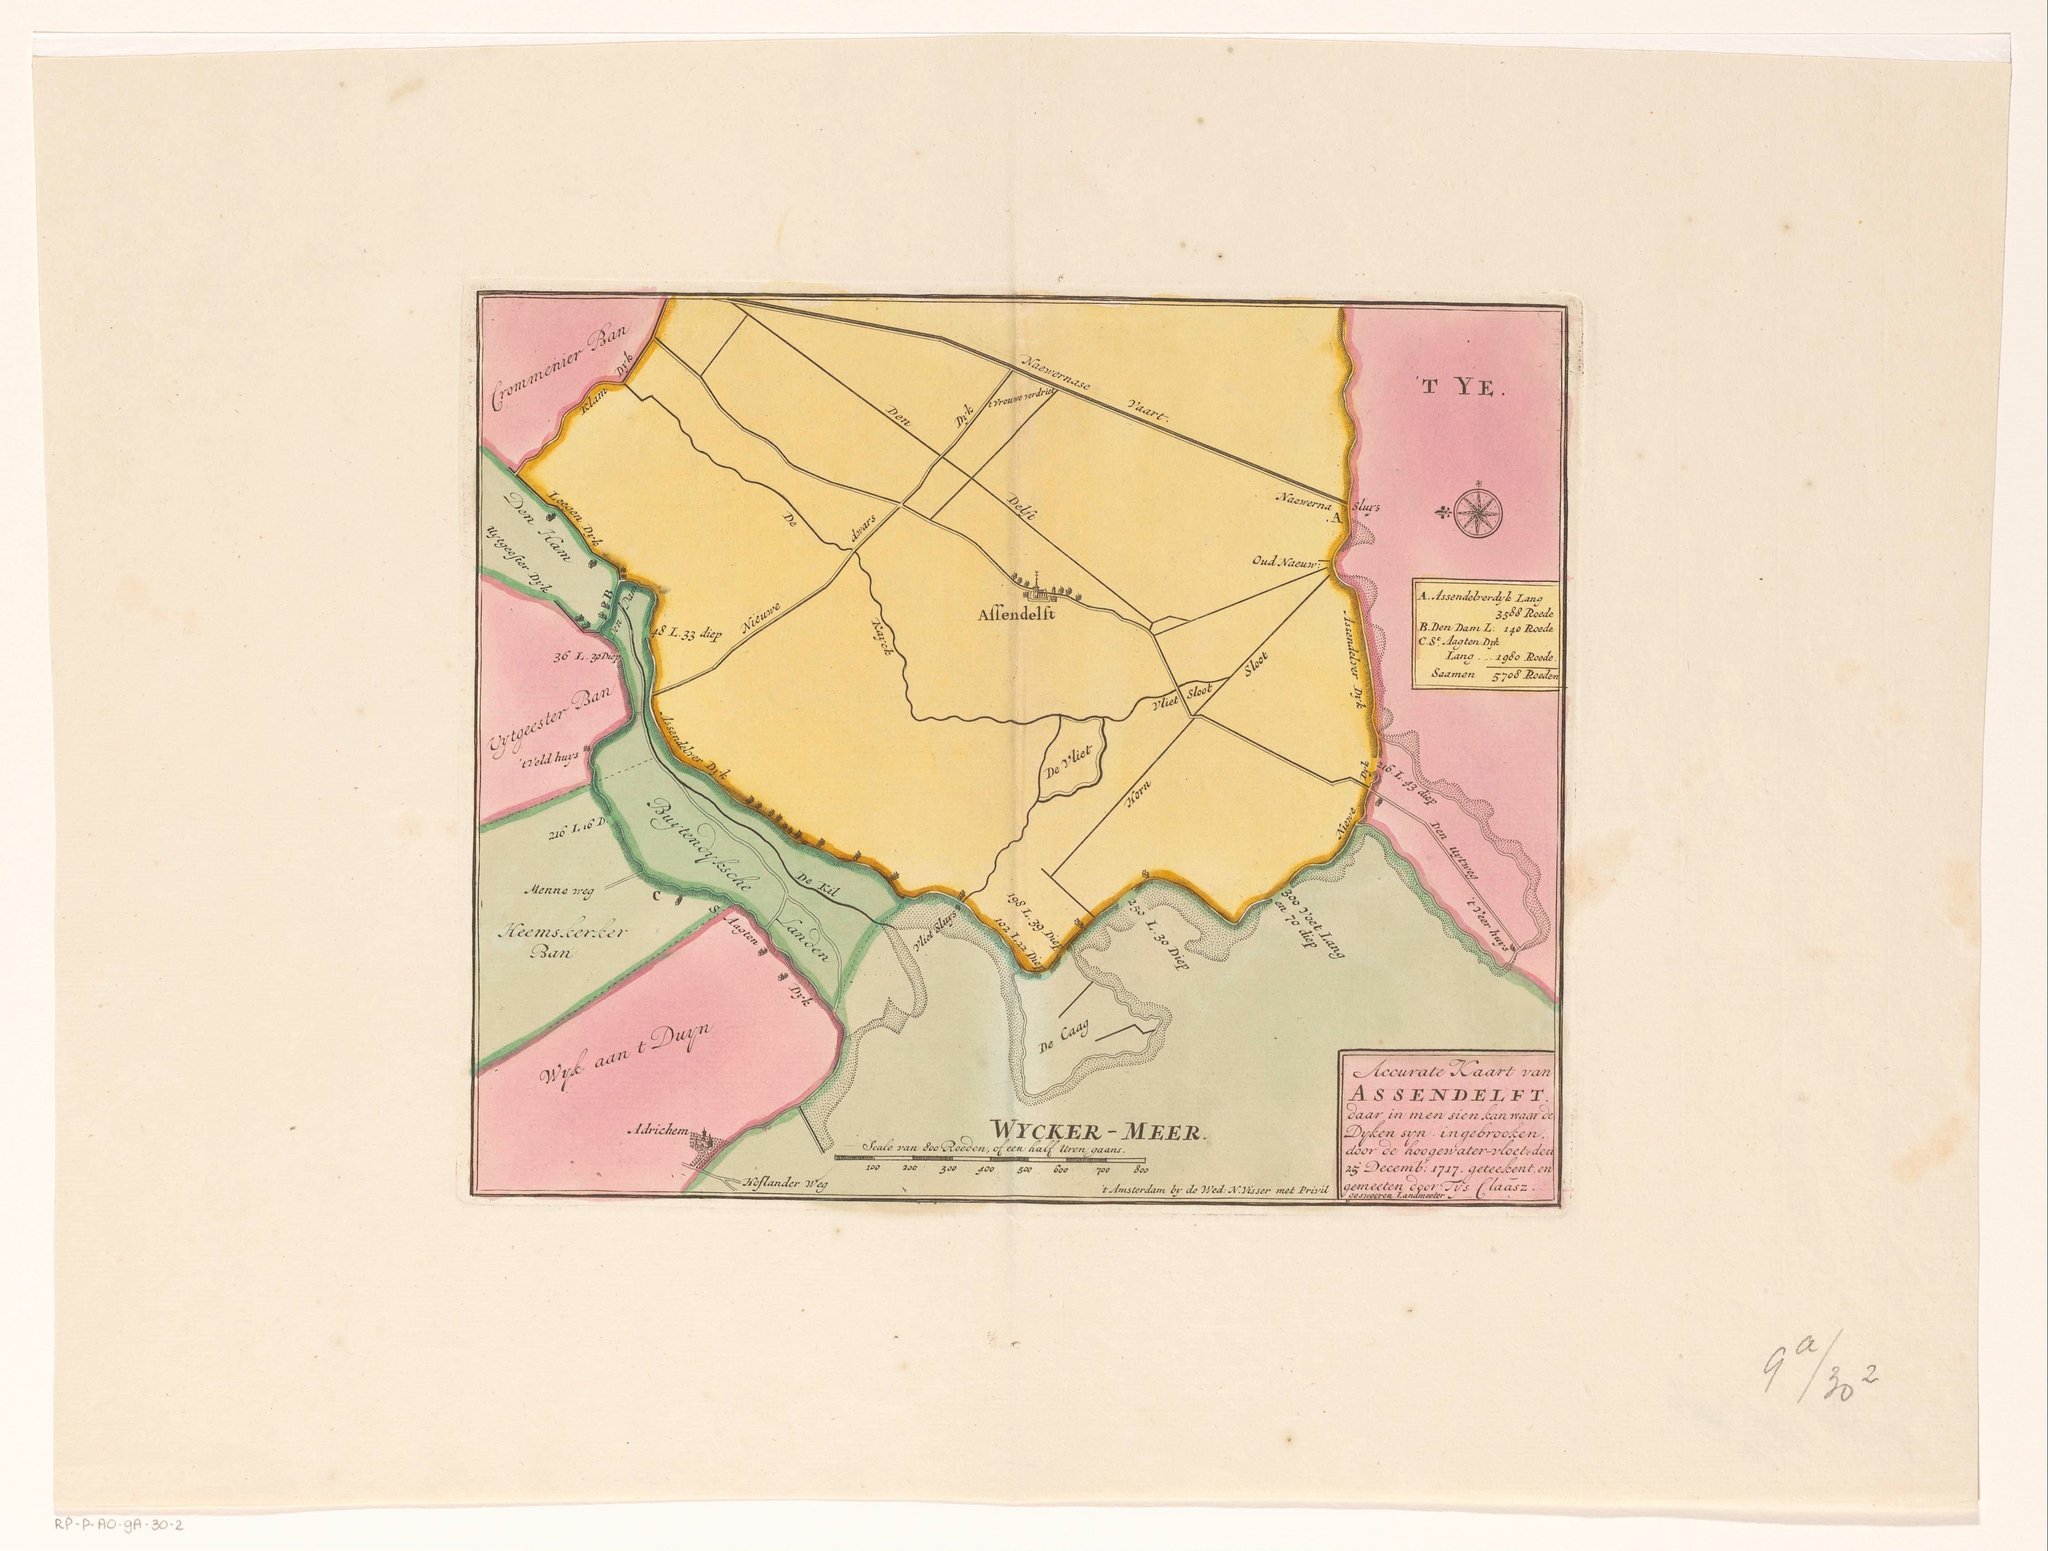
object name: map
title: Kaart van Assendelft met dijkdoorbraken, 1717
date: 1718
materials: paper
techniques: engraving, etching, hand coloring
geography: amsterdam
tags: dike-break, storm, maps of cities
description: Kaart van Assendelft waarop de dijkdoorbraken veroorzaakt door de Kerstvloed van 1717 te zien zijn. Onderaan in het midden een schaalstok: Scale van 800 roeden, of een half uren gaans. Rechts een legenda A-C, rechtsonder de titel.